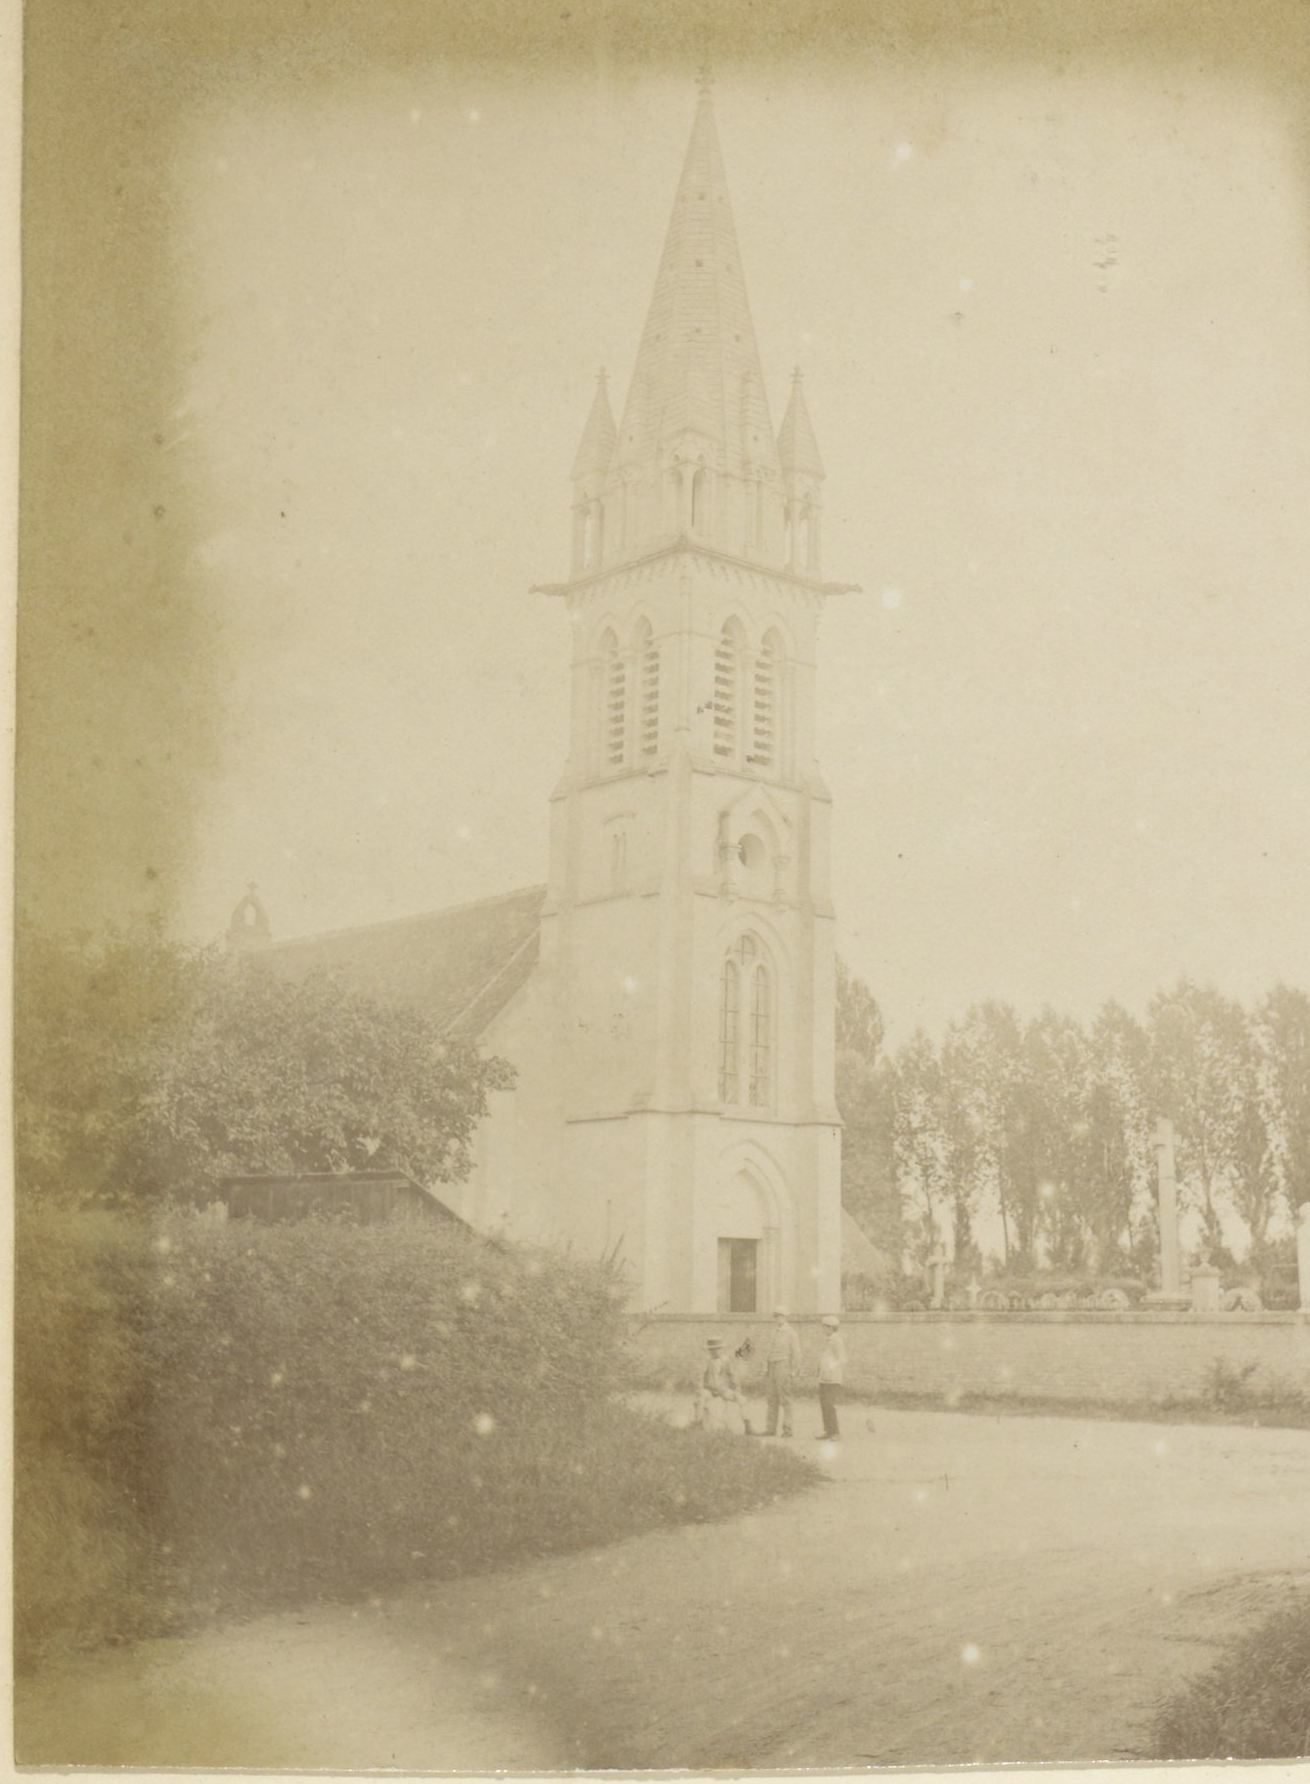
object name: photograph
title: Kerktoren in Frankrijk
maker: Anonymous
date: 1900-1910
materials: paper, photographic support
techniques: albumen print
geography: france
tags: parts of church exterior and annexes: tower, france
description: Onderdeel van Fotoalbum van een Franse amateurfotograaf met opnames van een familie, distilleerderij Delizy & Doistau Fils, het leger en bezienswaardigheden in Frankrijk.